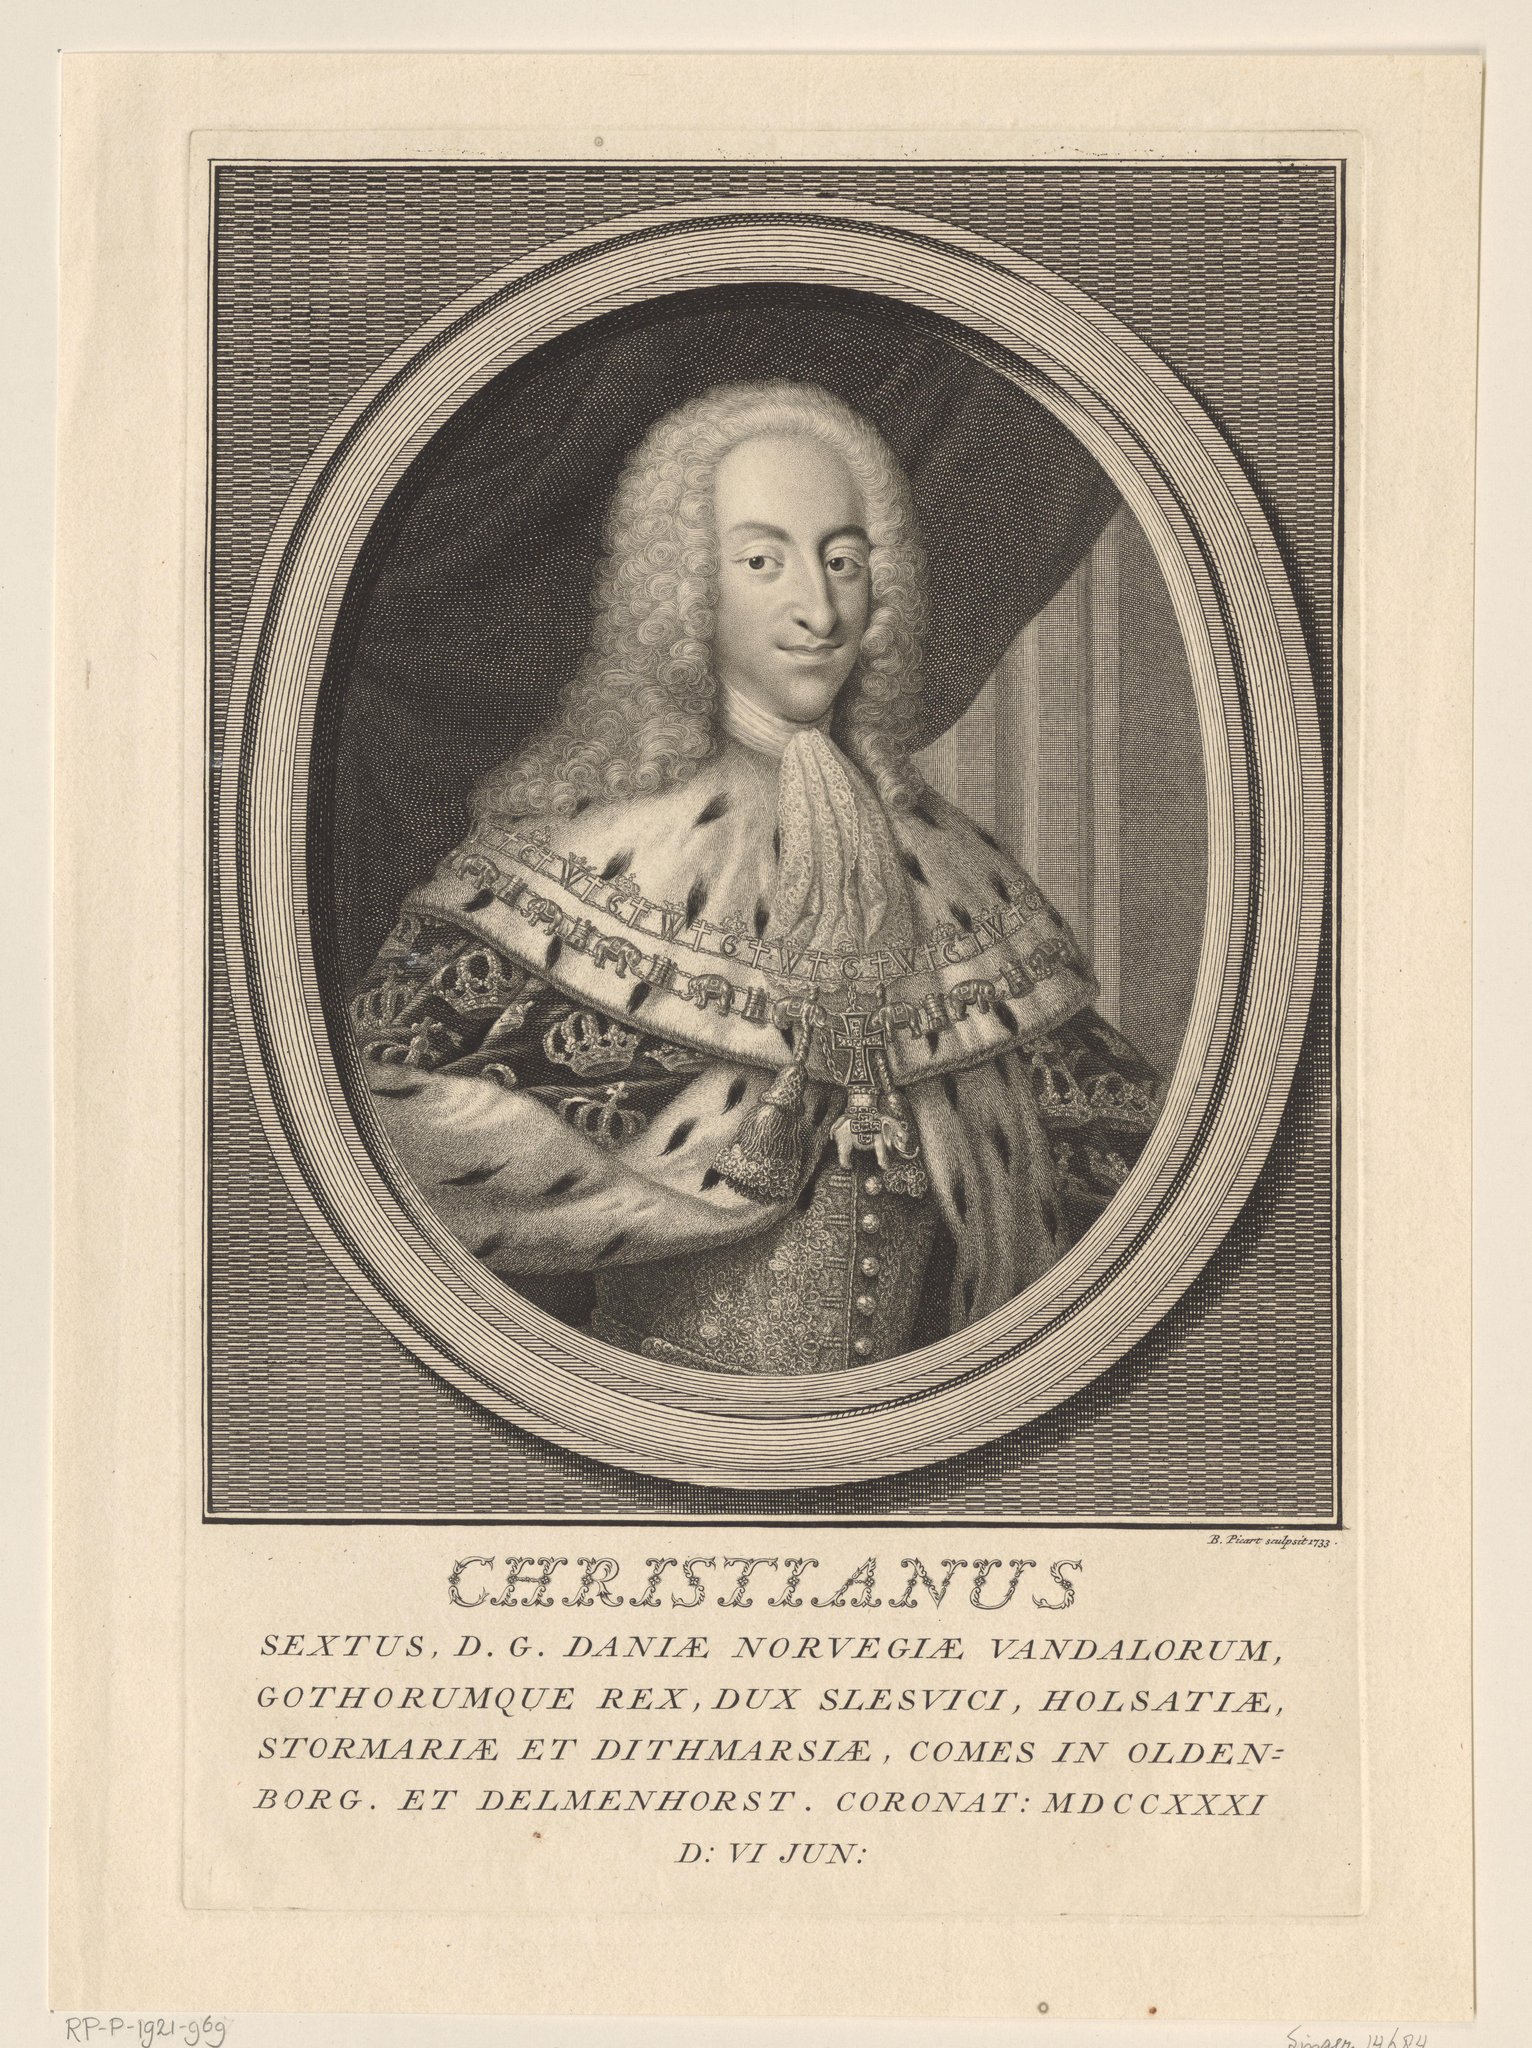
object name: print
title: Portret van Christiaan VI, koning van Denemarken en Noorwegen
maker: bernard picart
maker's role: draughtsman, print maker, publisher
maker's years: 1673-1733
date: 1733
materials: paper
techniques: engraving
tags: copenhagen (city), historical persons, king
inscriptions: collector's mark: Lugt 2233